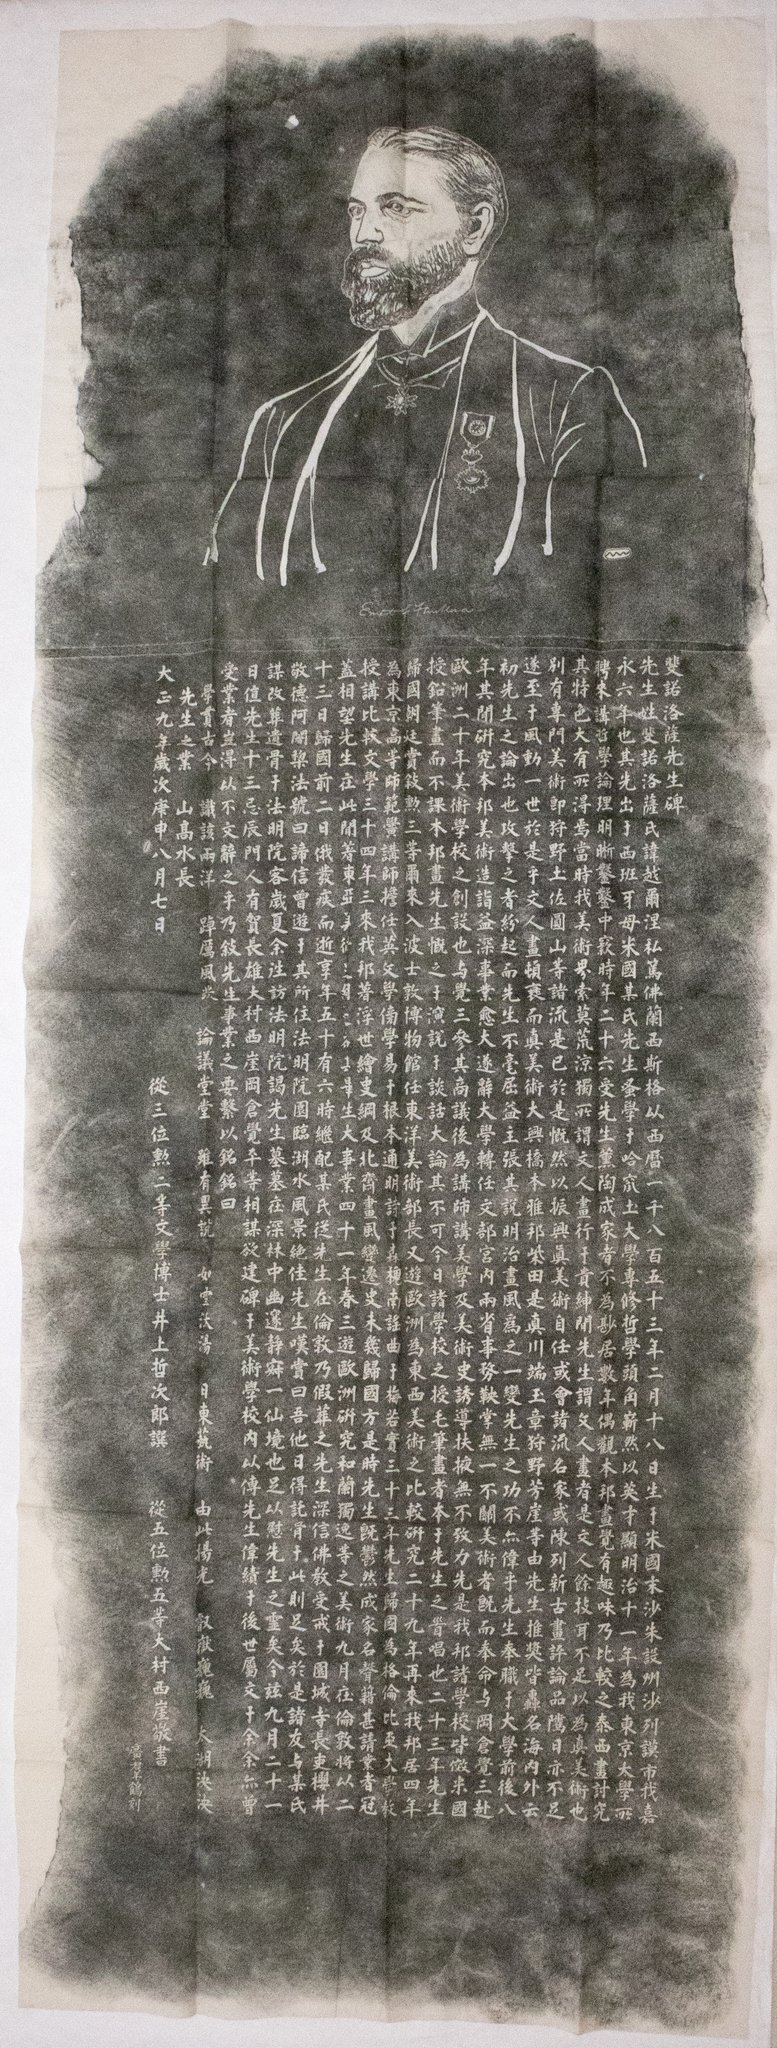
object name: rubbing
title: Rubbing of a Stone Monument to Ernest Fenollosa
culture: japanese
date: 1901-2000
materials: ink, paper